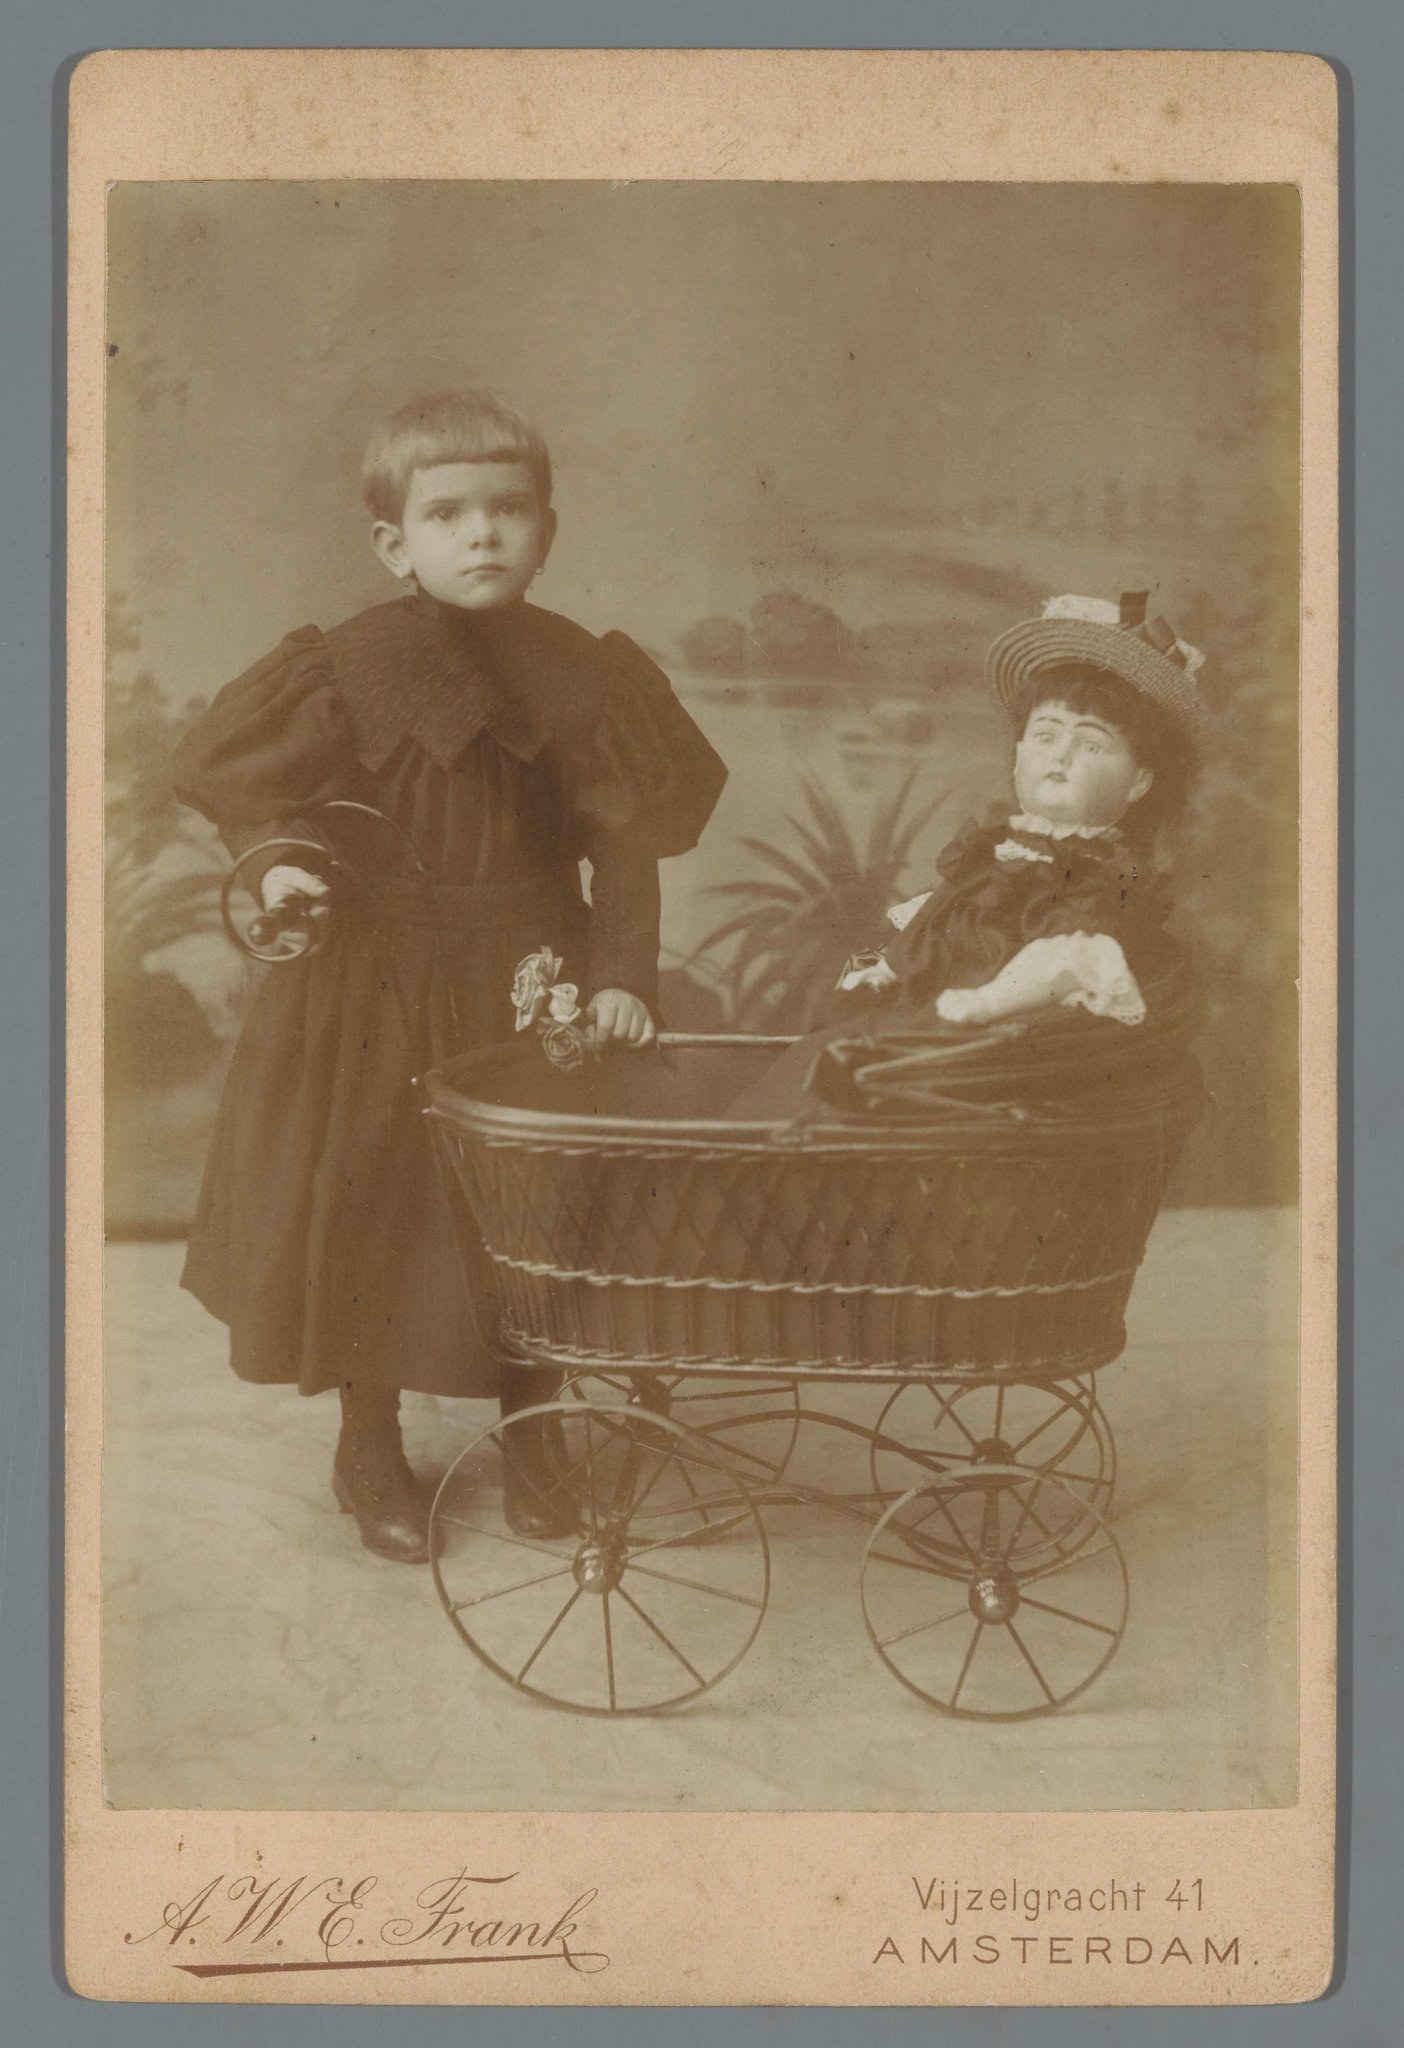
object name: cabinet photograph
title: Portret van een onbekend meisje met een poppenwagen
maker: a.w.e. frank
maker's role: fotograaf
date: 1890-1910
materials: cardboard, photographic support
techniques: daylight paper print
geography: amsterdam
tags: (playing with) dolls, child (at home) - aa - girl